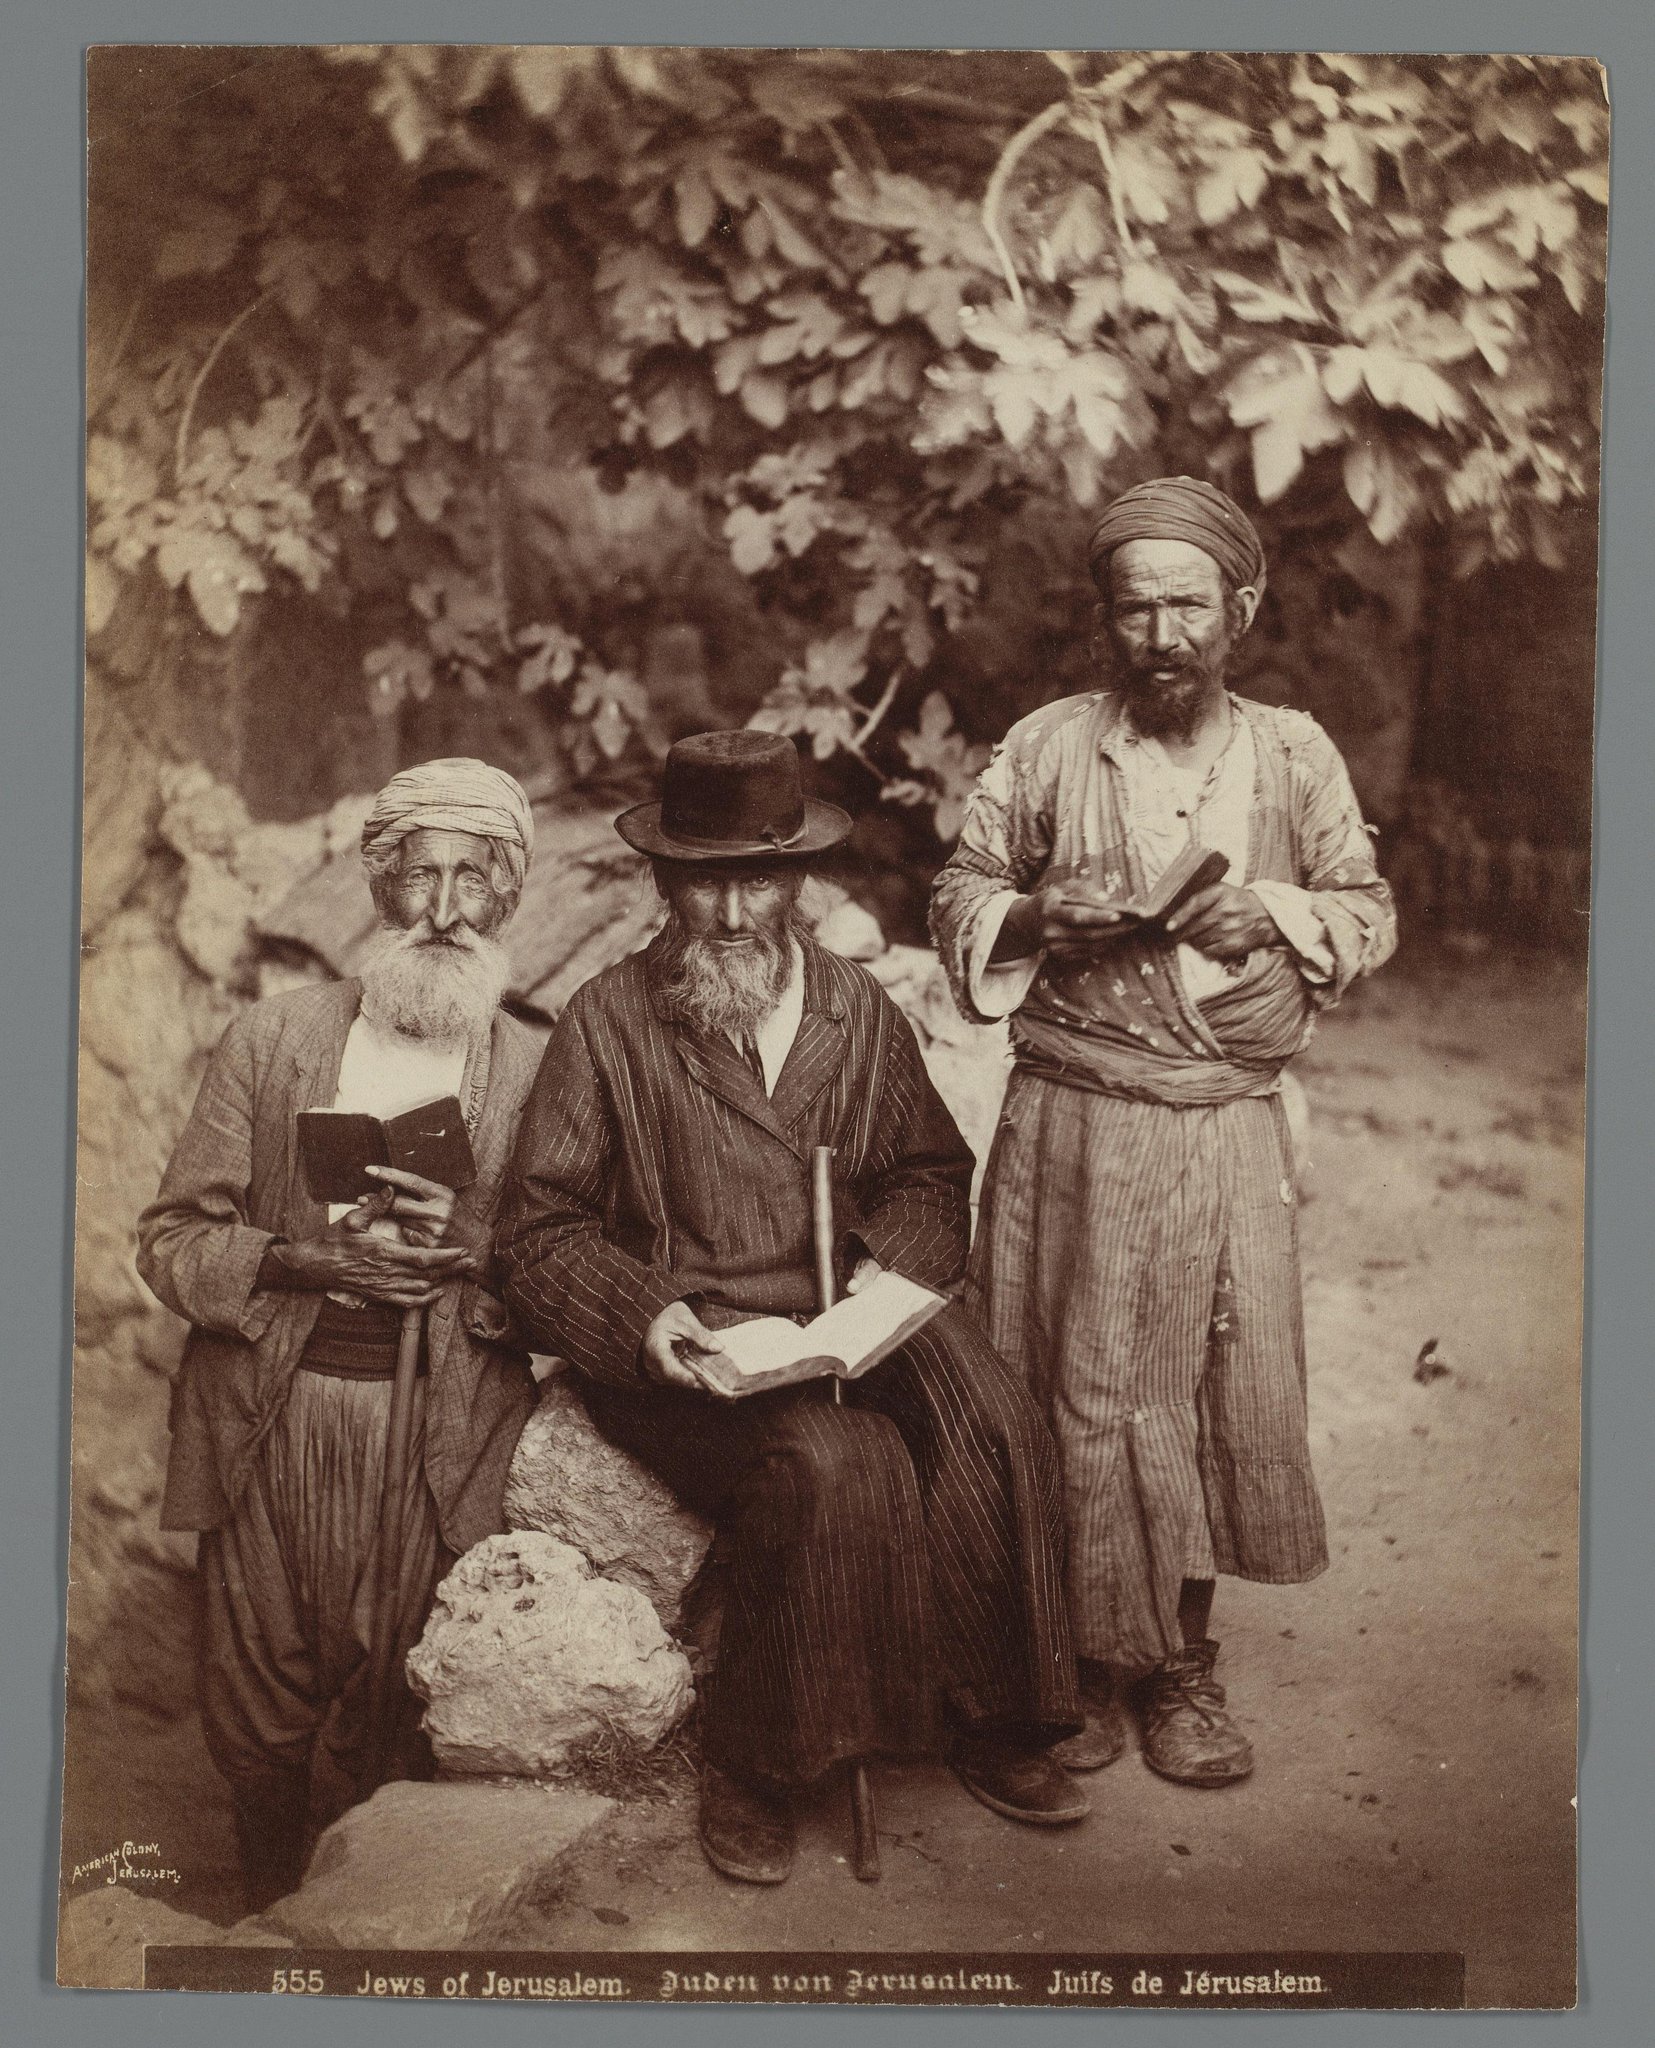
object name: photograph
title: Jews of Jerusalem / Juden von Jerusalem / Juis de Jérusalem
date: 1898-1910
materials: paper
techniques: albumen print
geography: jerusalem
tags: adult man, anonymous historical persons portrayed in a group, in a group-portrait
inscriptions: number: ‘555’